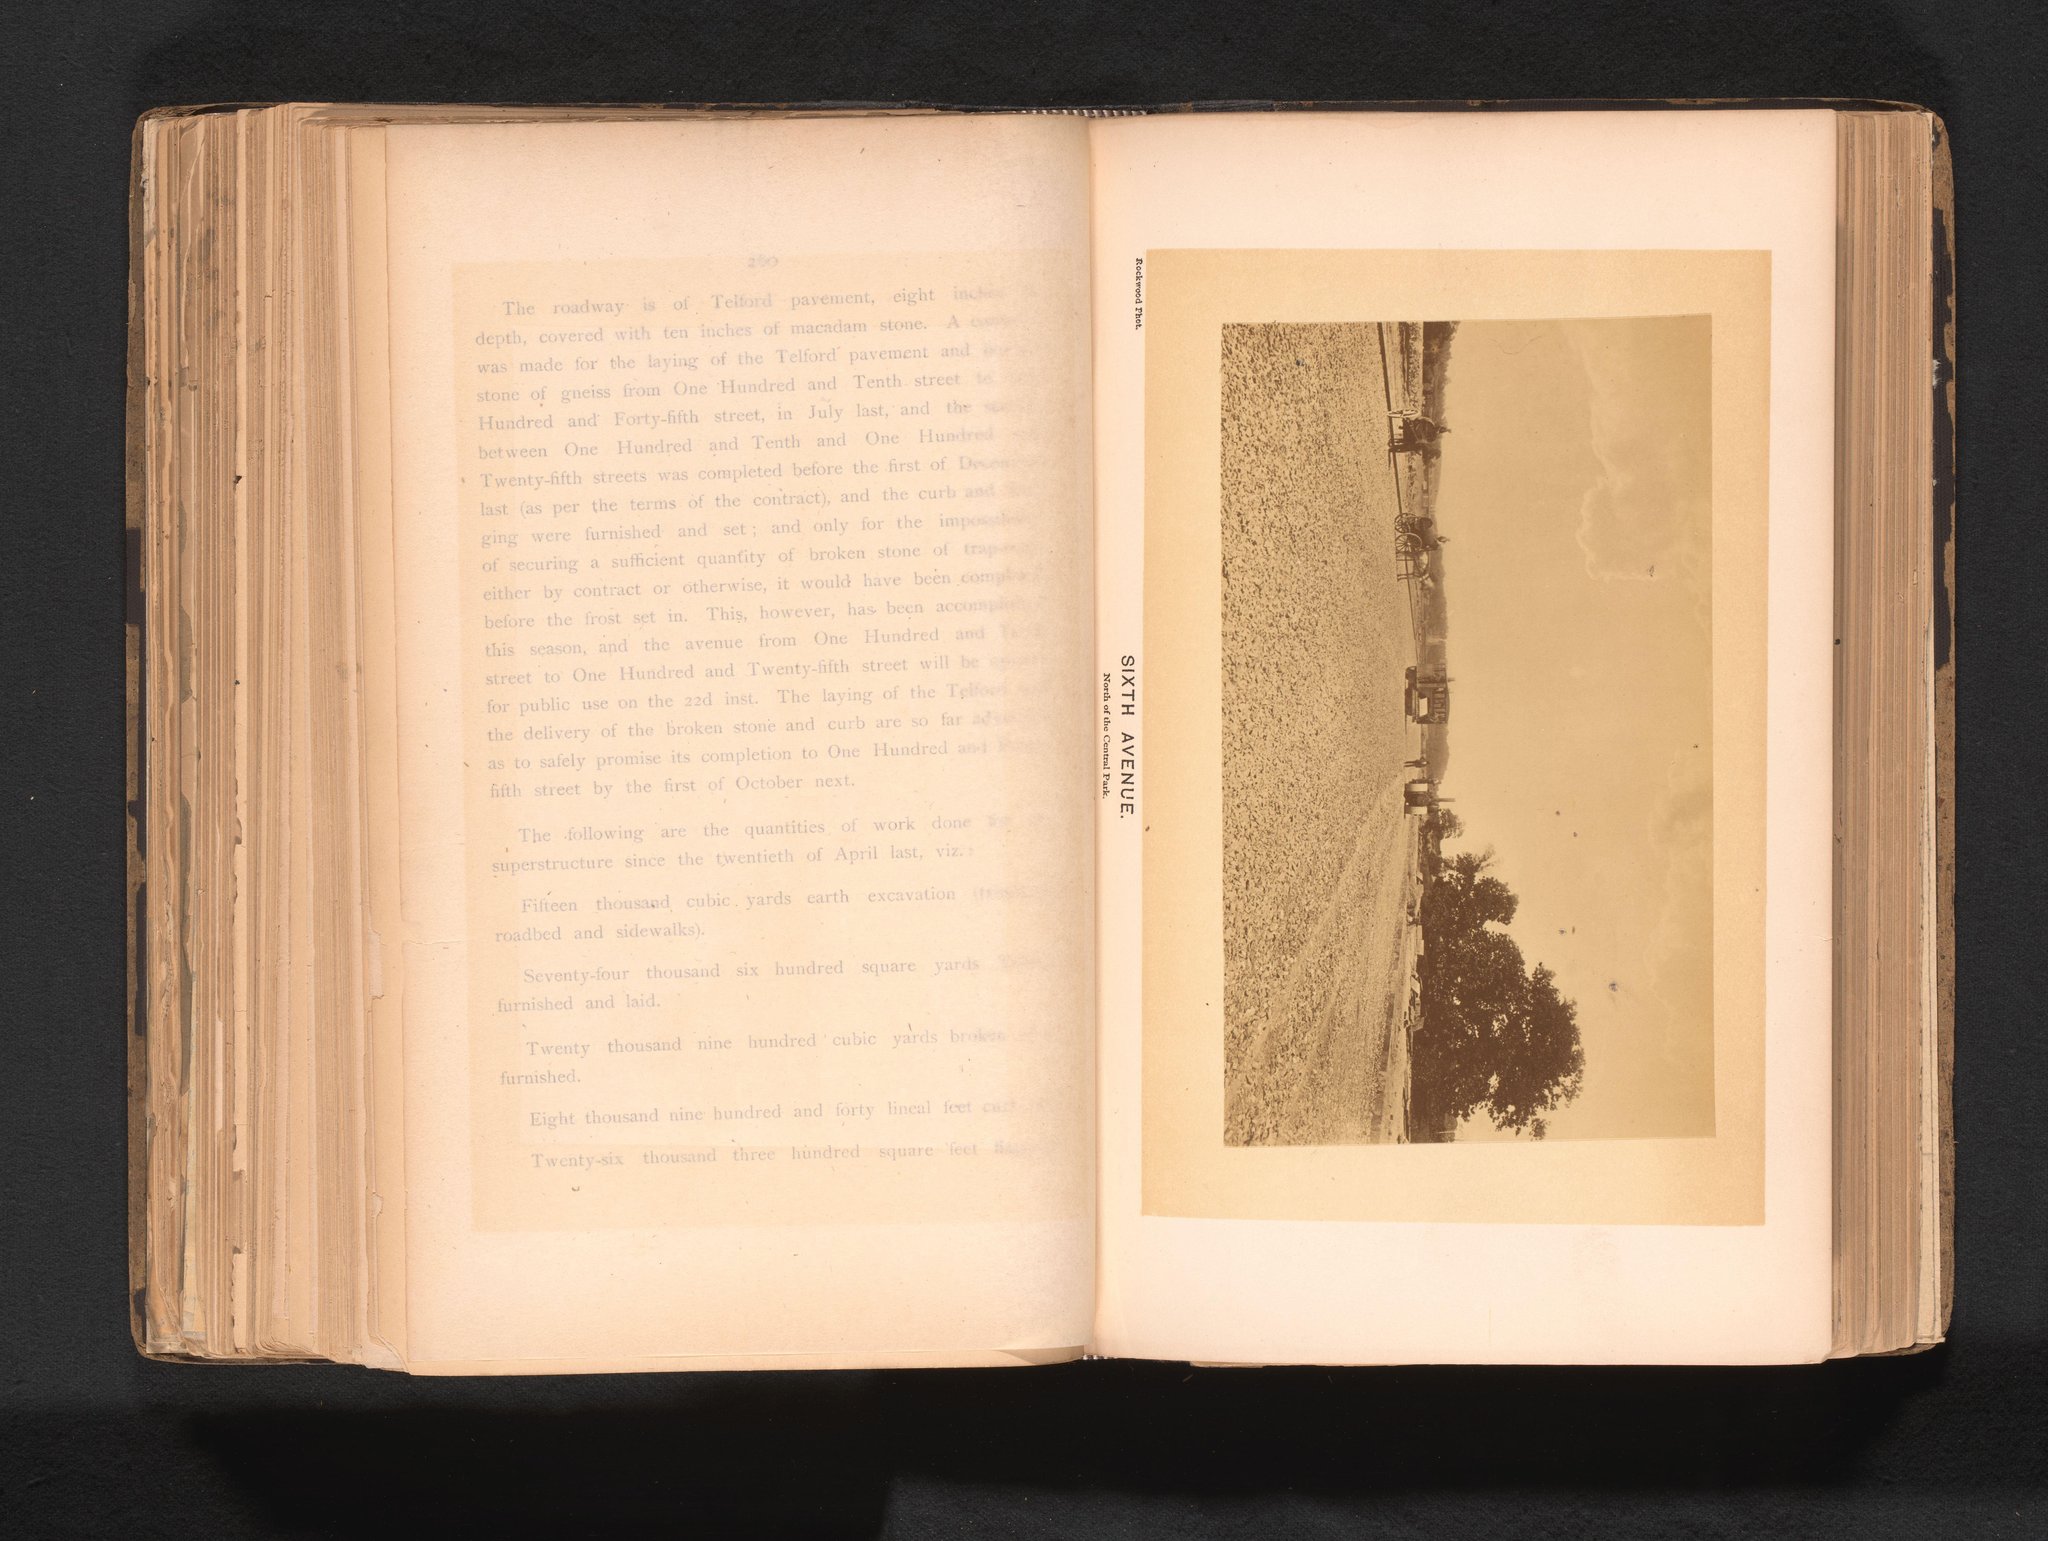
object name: photograph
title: Sixth Avenue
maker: george gardner rockwood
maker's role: fotograaf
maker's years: 1832-1911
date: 1866-1871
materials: photographic support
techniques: albumen print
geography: central park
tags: avenue, boulevard, promenade, esplanade, public gardens, park